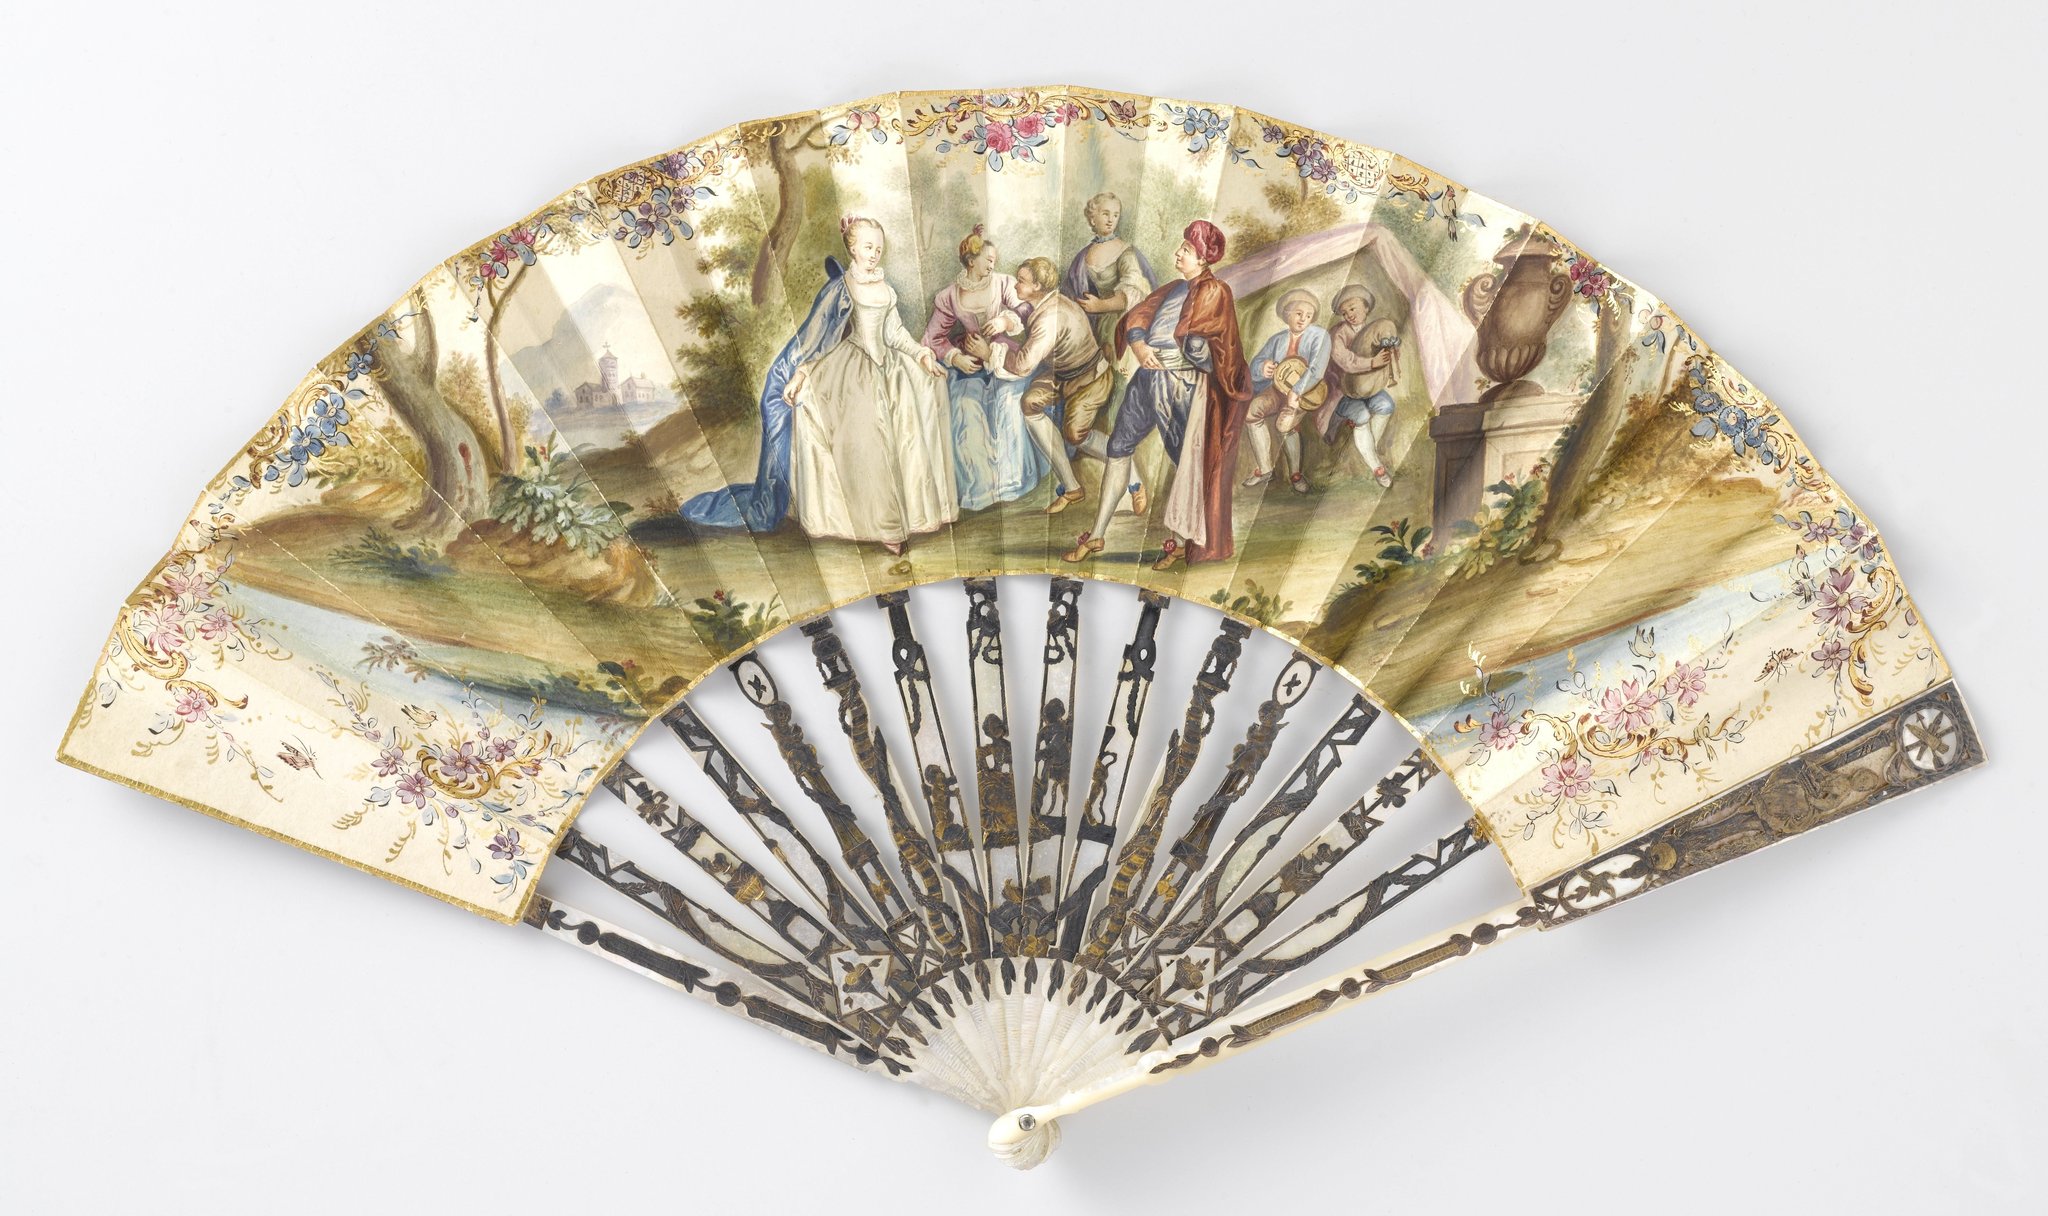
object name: vouwwaaier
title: Vouwwaaier met een blad waarop in aquarel een buitenpartij met een dansend paar en doedelzakspelers, op een montuur van parelmoer met 'métal en quattre couleurs'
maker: Anonymous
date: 1775-1780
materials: gold leaf, mother of pearl, paint, parchment, silver leaf, watercolor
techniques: cutting, inlay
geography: france